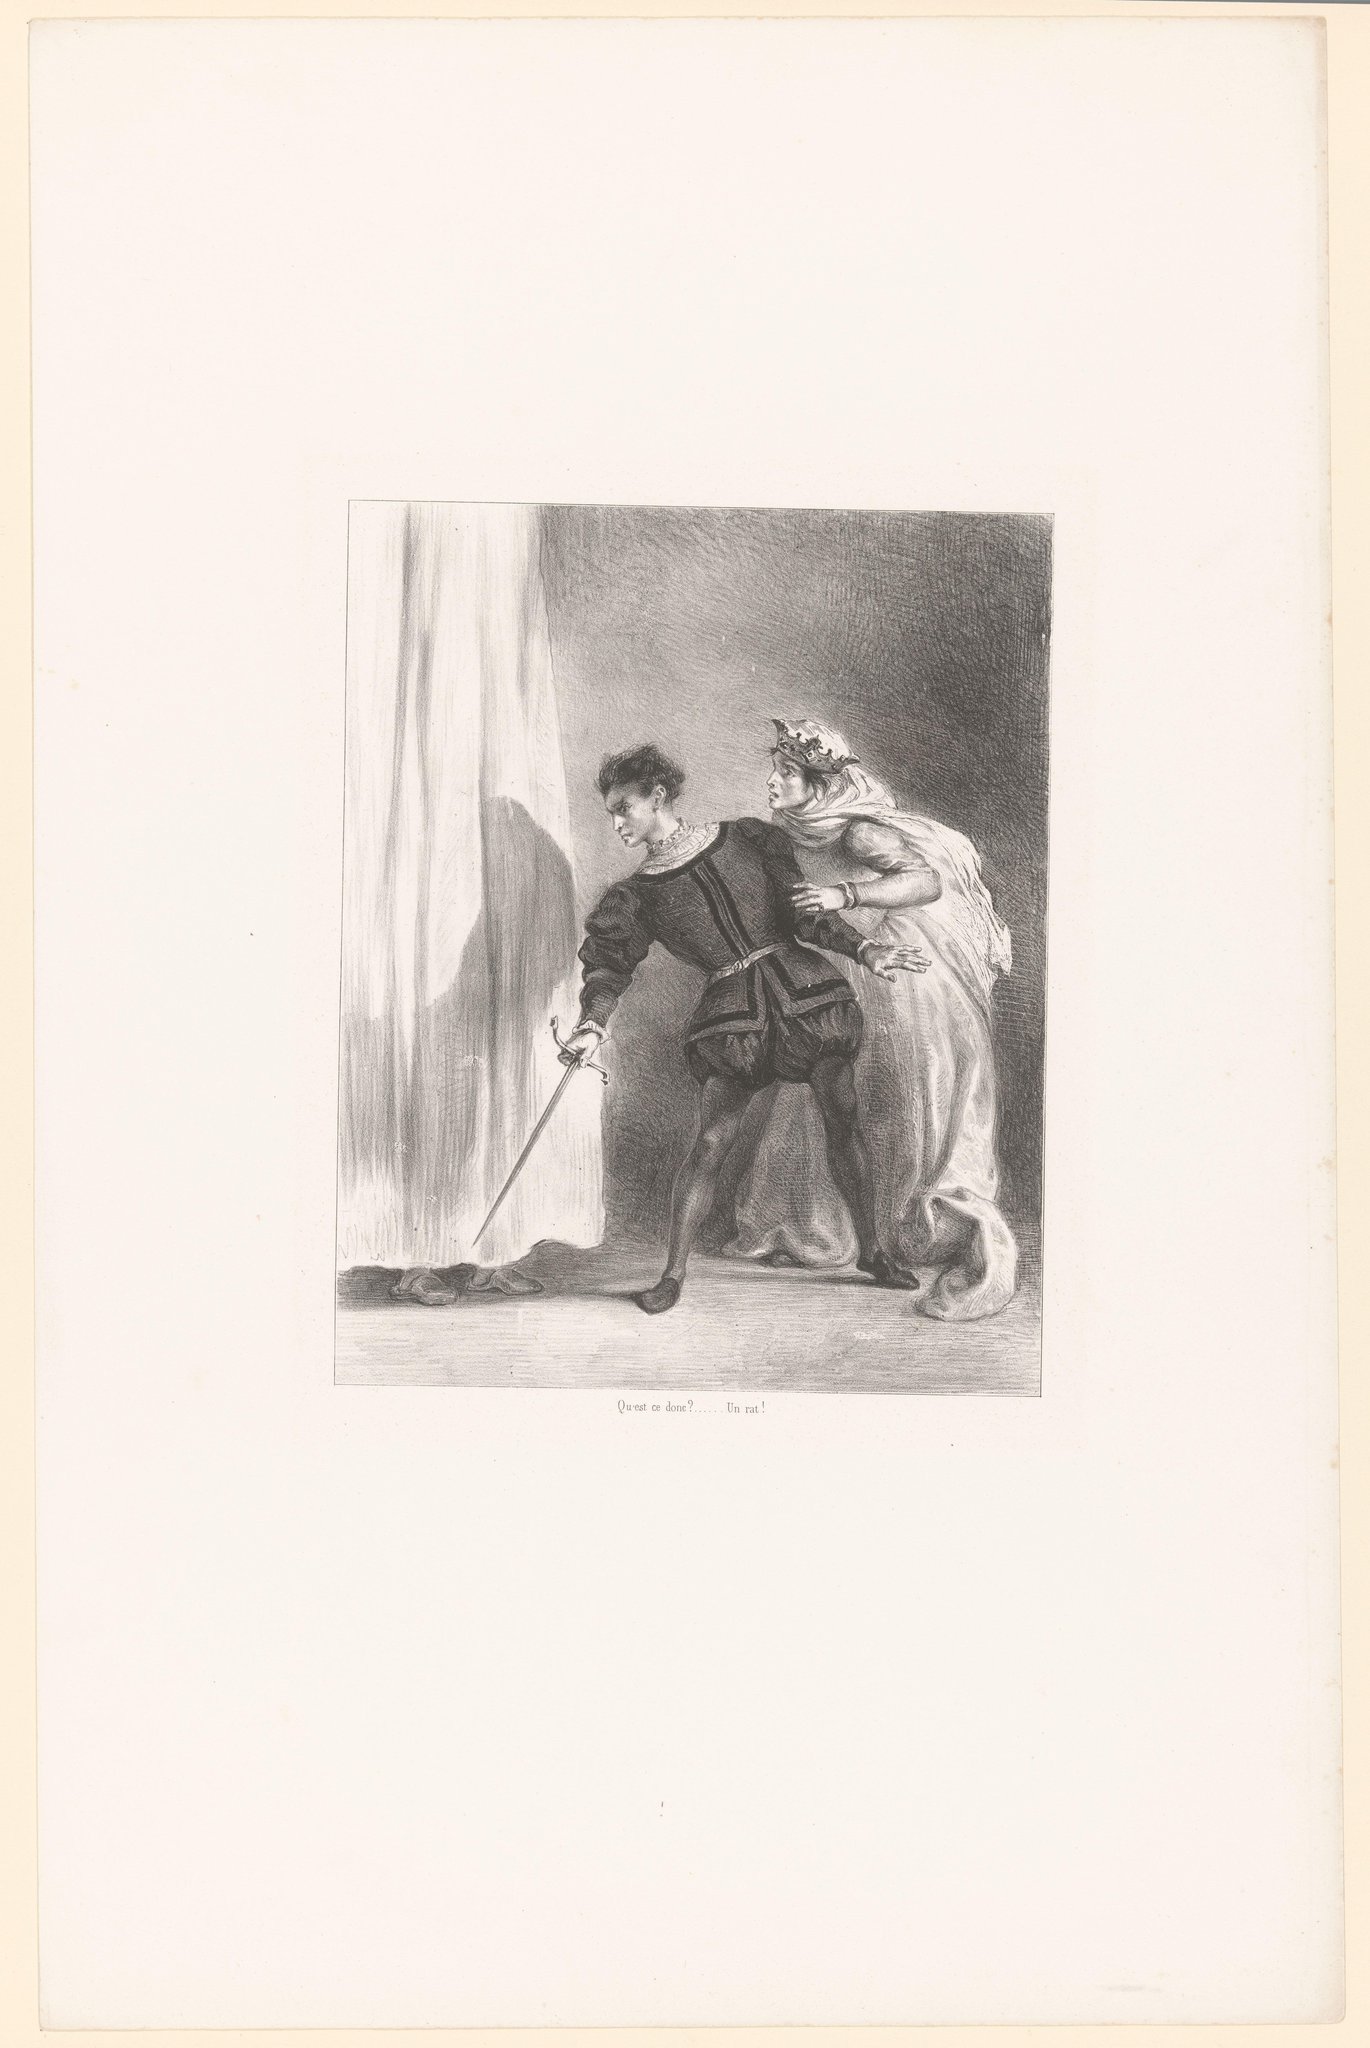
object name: print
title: Hamlet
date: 1834-1863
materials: paper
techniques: lithograph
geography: paris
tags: hamlet, prince of denmark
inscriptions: collector's mark: Lugt 2228a, collector's mark: Lugt 2760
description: Prent maakt deel uit van een omslag met veertien prenten.